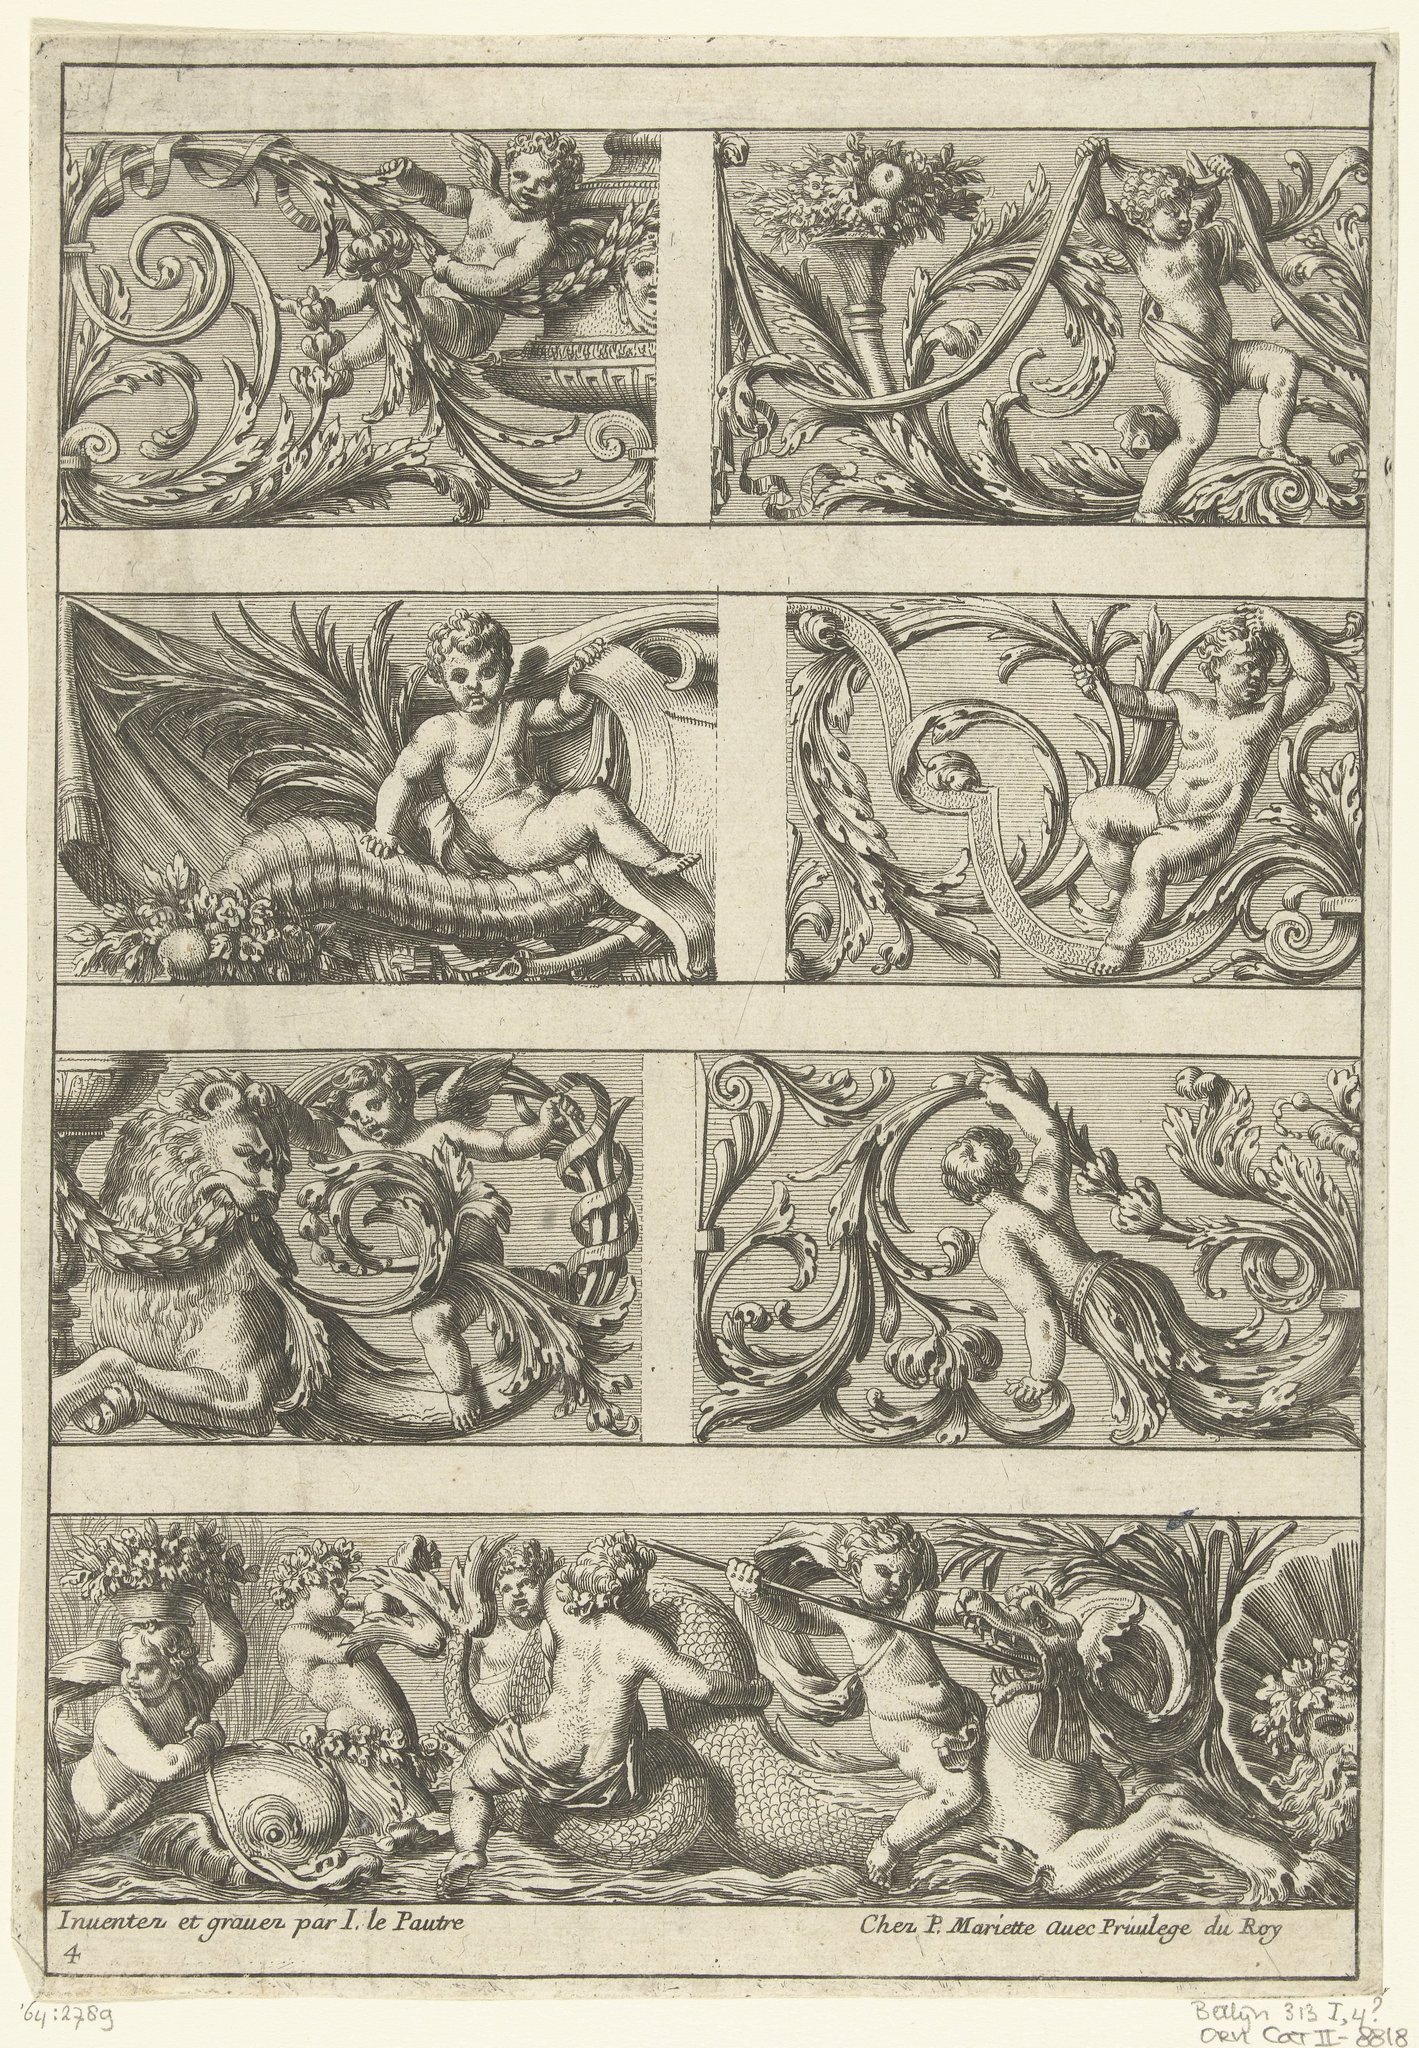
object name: ornament print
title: Vier rijen friezen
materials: paper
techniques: etching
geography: france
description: Op het onderste fries staan vijf putti, een van hen zit op een dolfijn terwijl een ander een zeepaard doodt met een lans. Blad 4 uit serie van 6 bladen, elk met vier rijen friezen, meestal verdeeld in twee tot vier compartimenten.